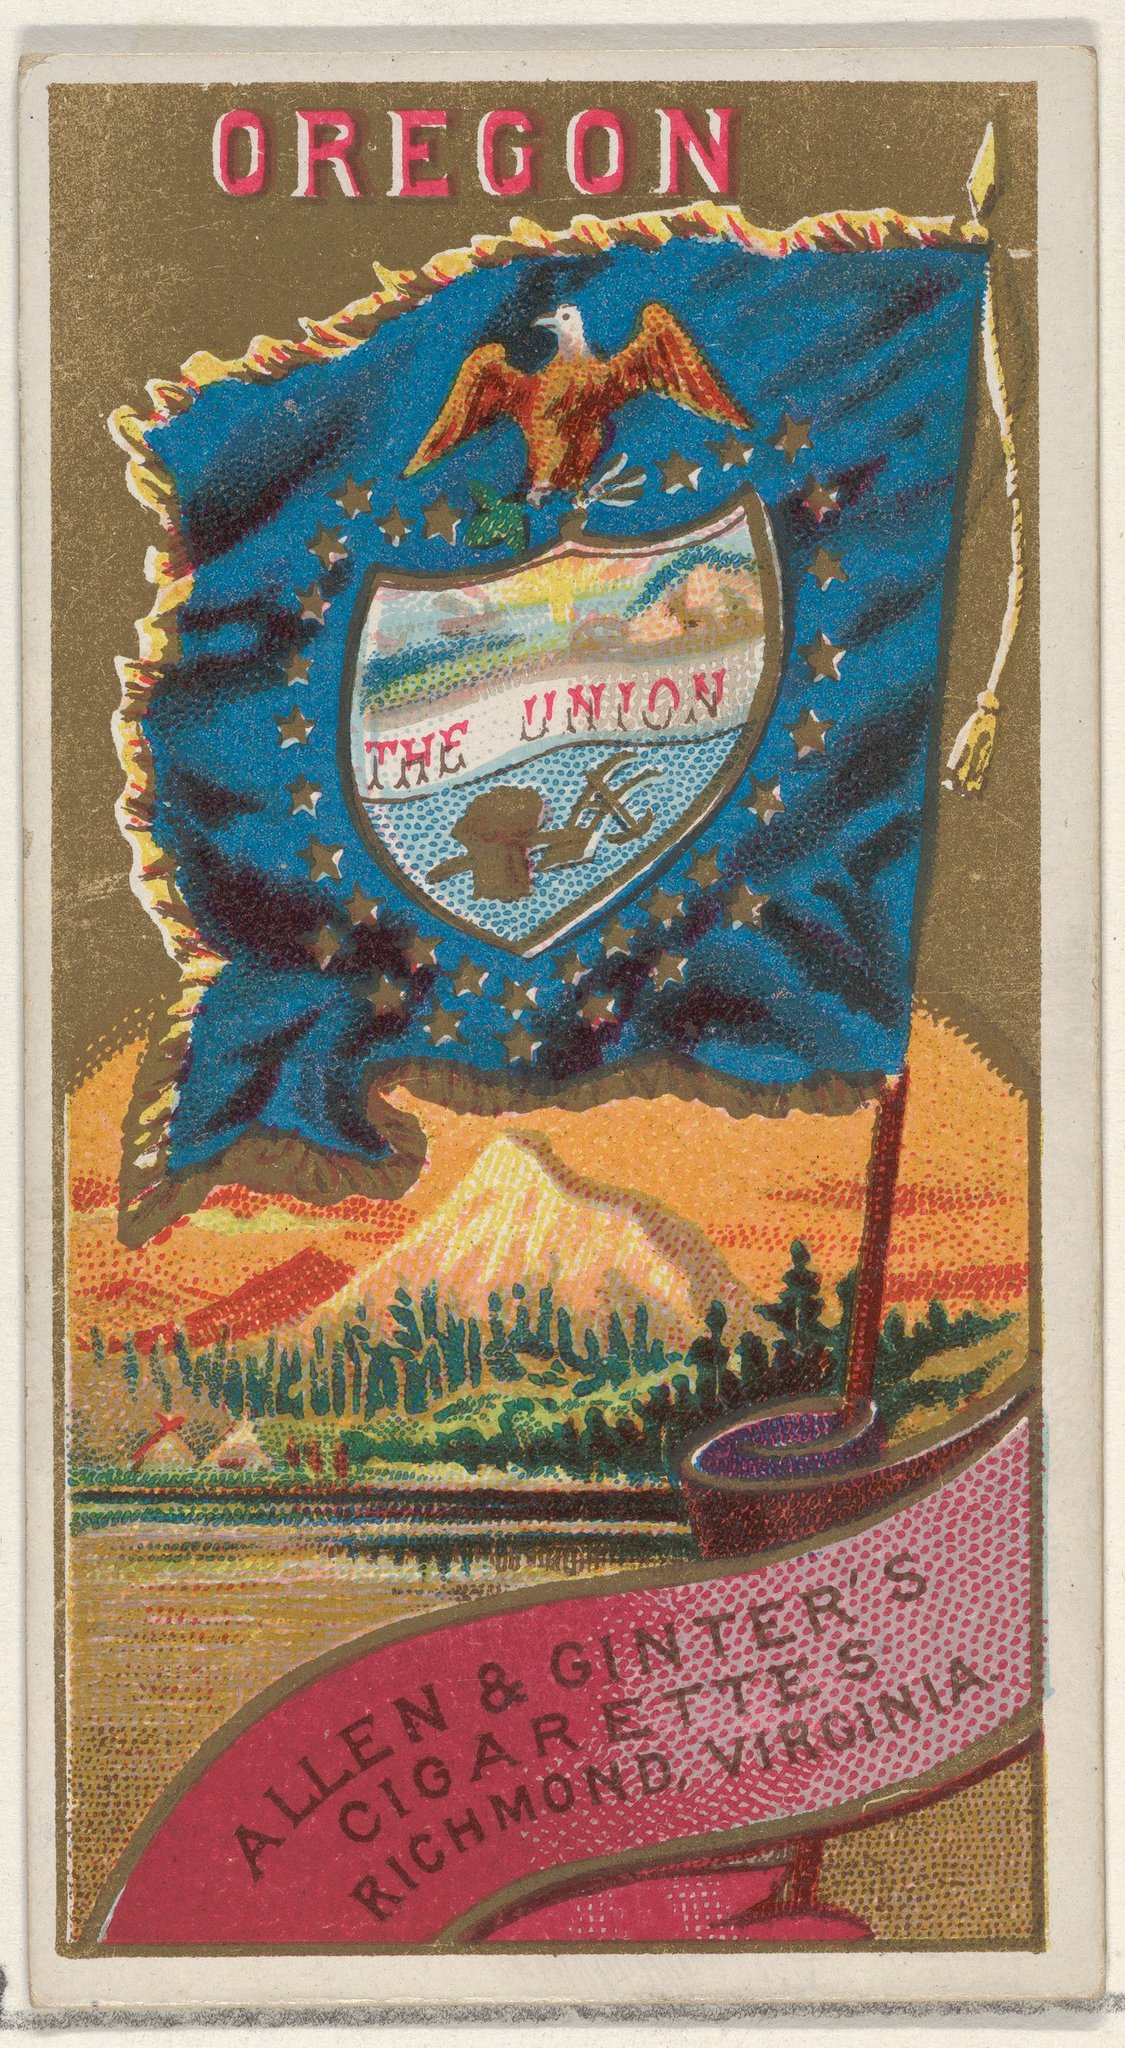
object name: print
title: Oregon, from Flags of the States and Territories (N11) for Allen & Ginter Cigarettes Brands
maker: allen & ginter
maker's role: publisher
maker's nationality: american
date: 1888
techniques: color lithograph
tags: flags